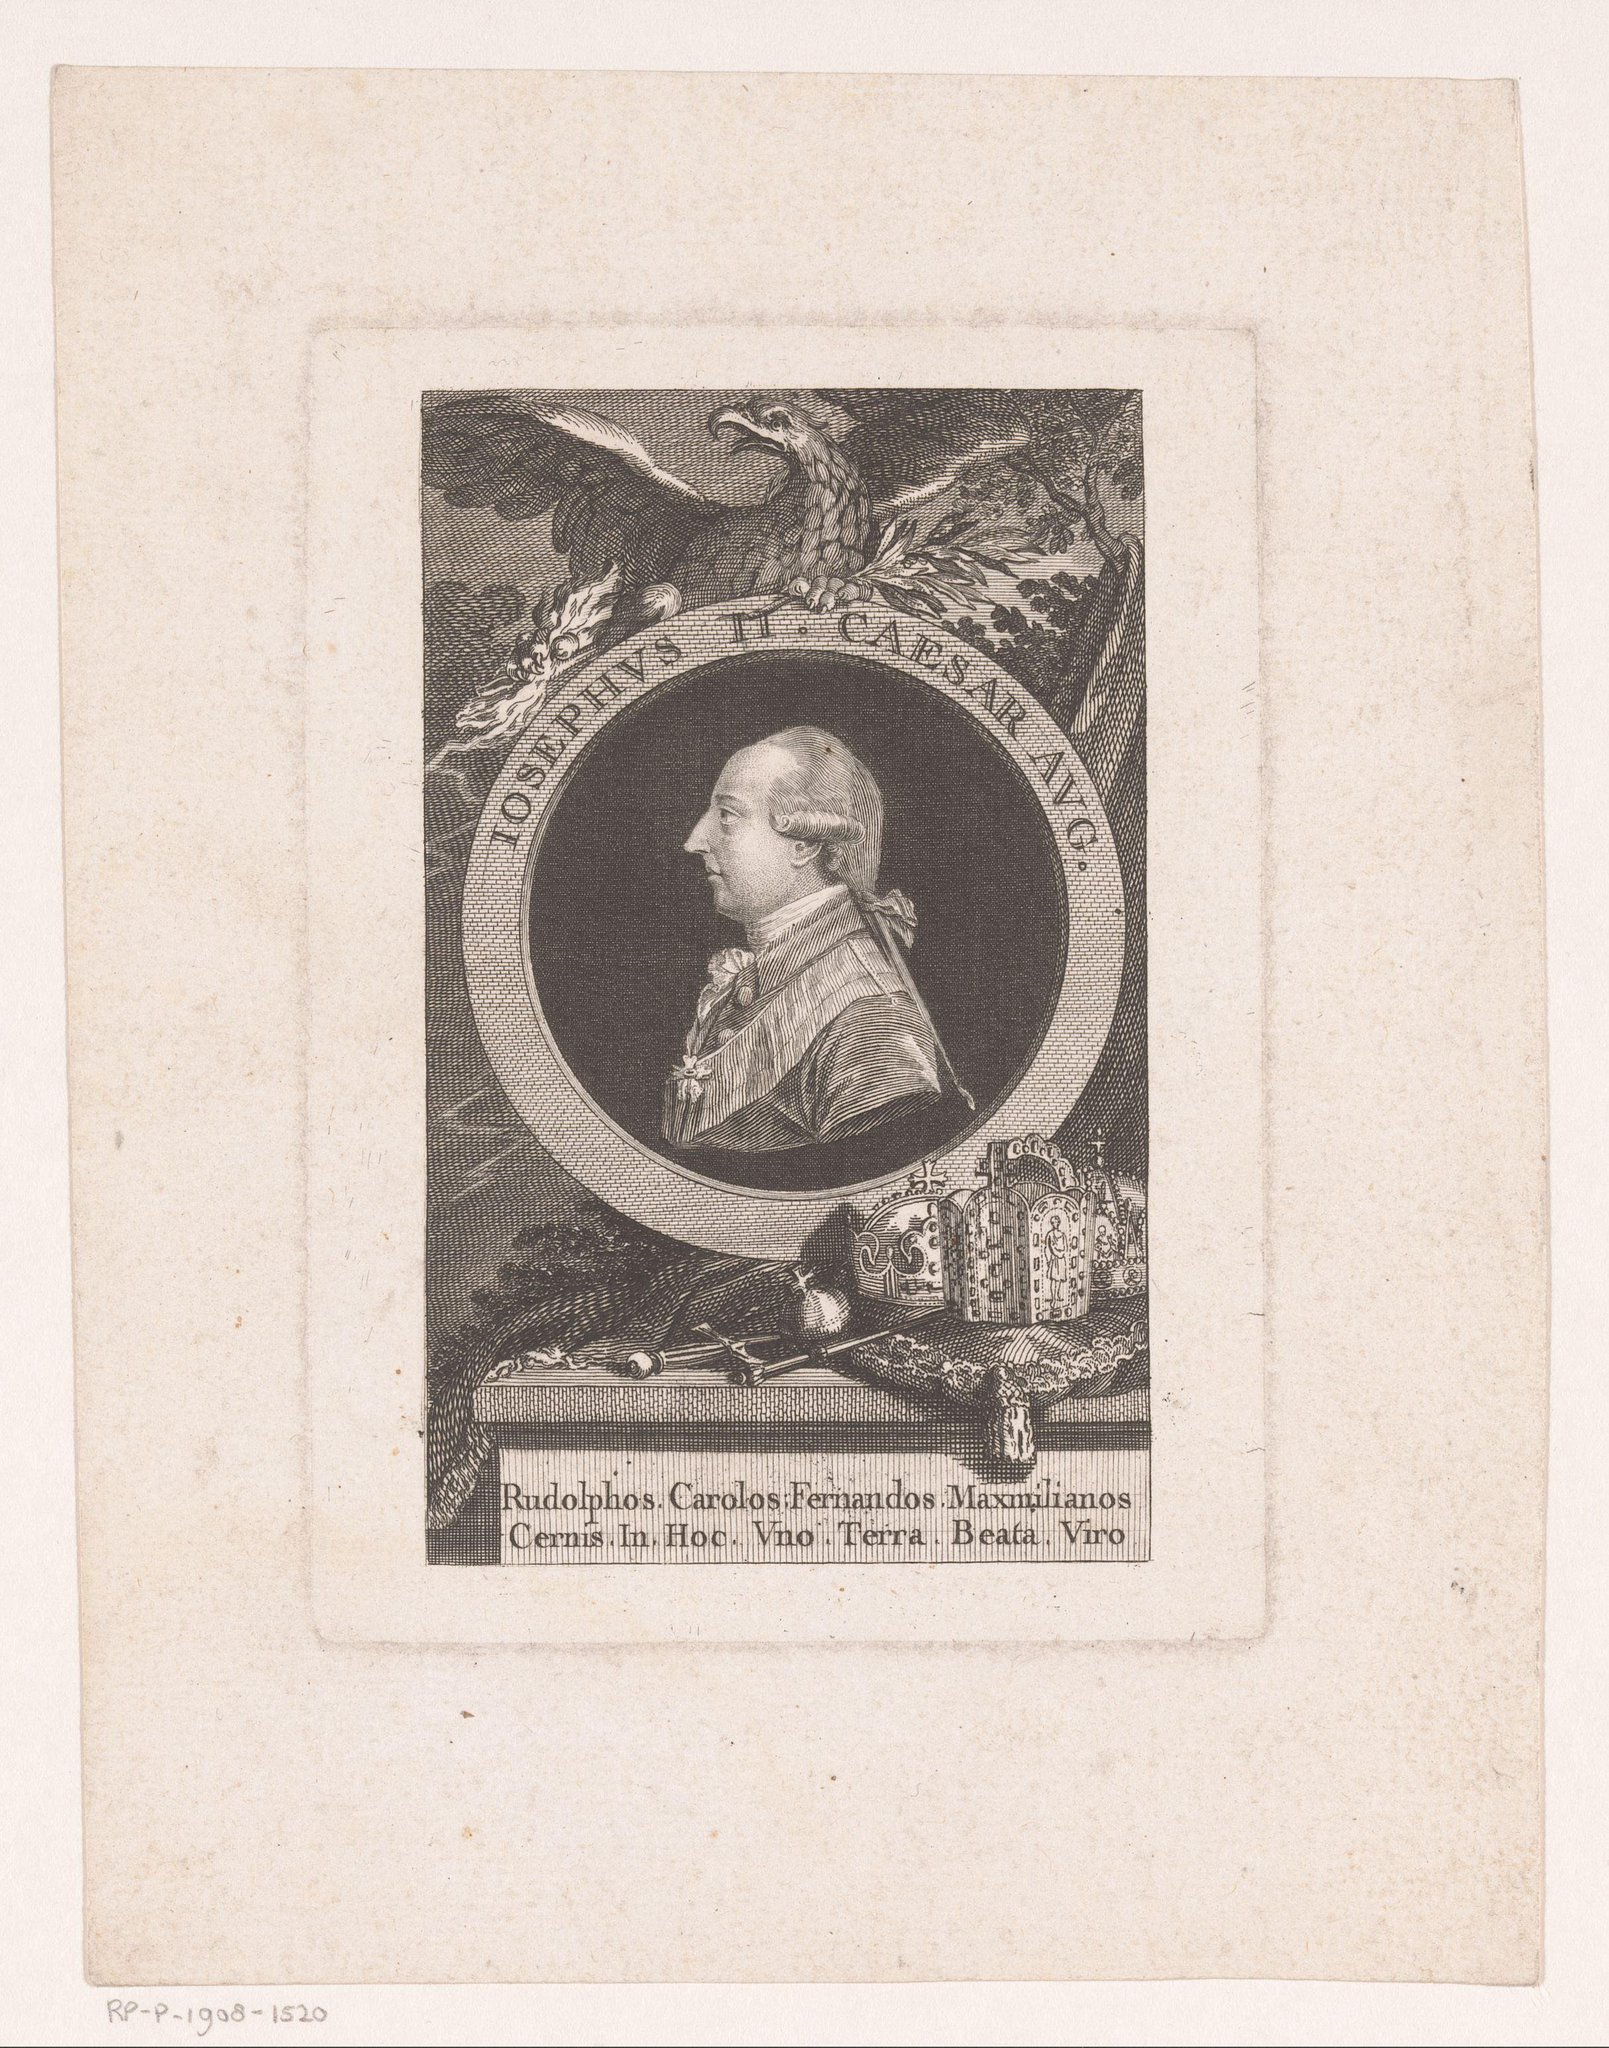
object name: print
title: Portret van keizer Jozef II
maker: Anonymous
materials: paper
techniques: engraving, etching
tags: jozef ii (duits keizer), historical persons, insignia and symbols of sovereignty (crown, diadem, sceptre, orb, seal, standard, cloak, pectoral)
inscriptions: collector's mark: Lugt 2228